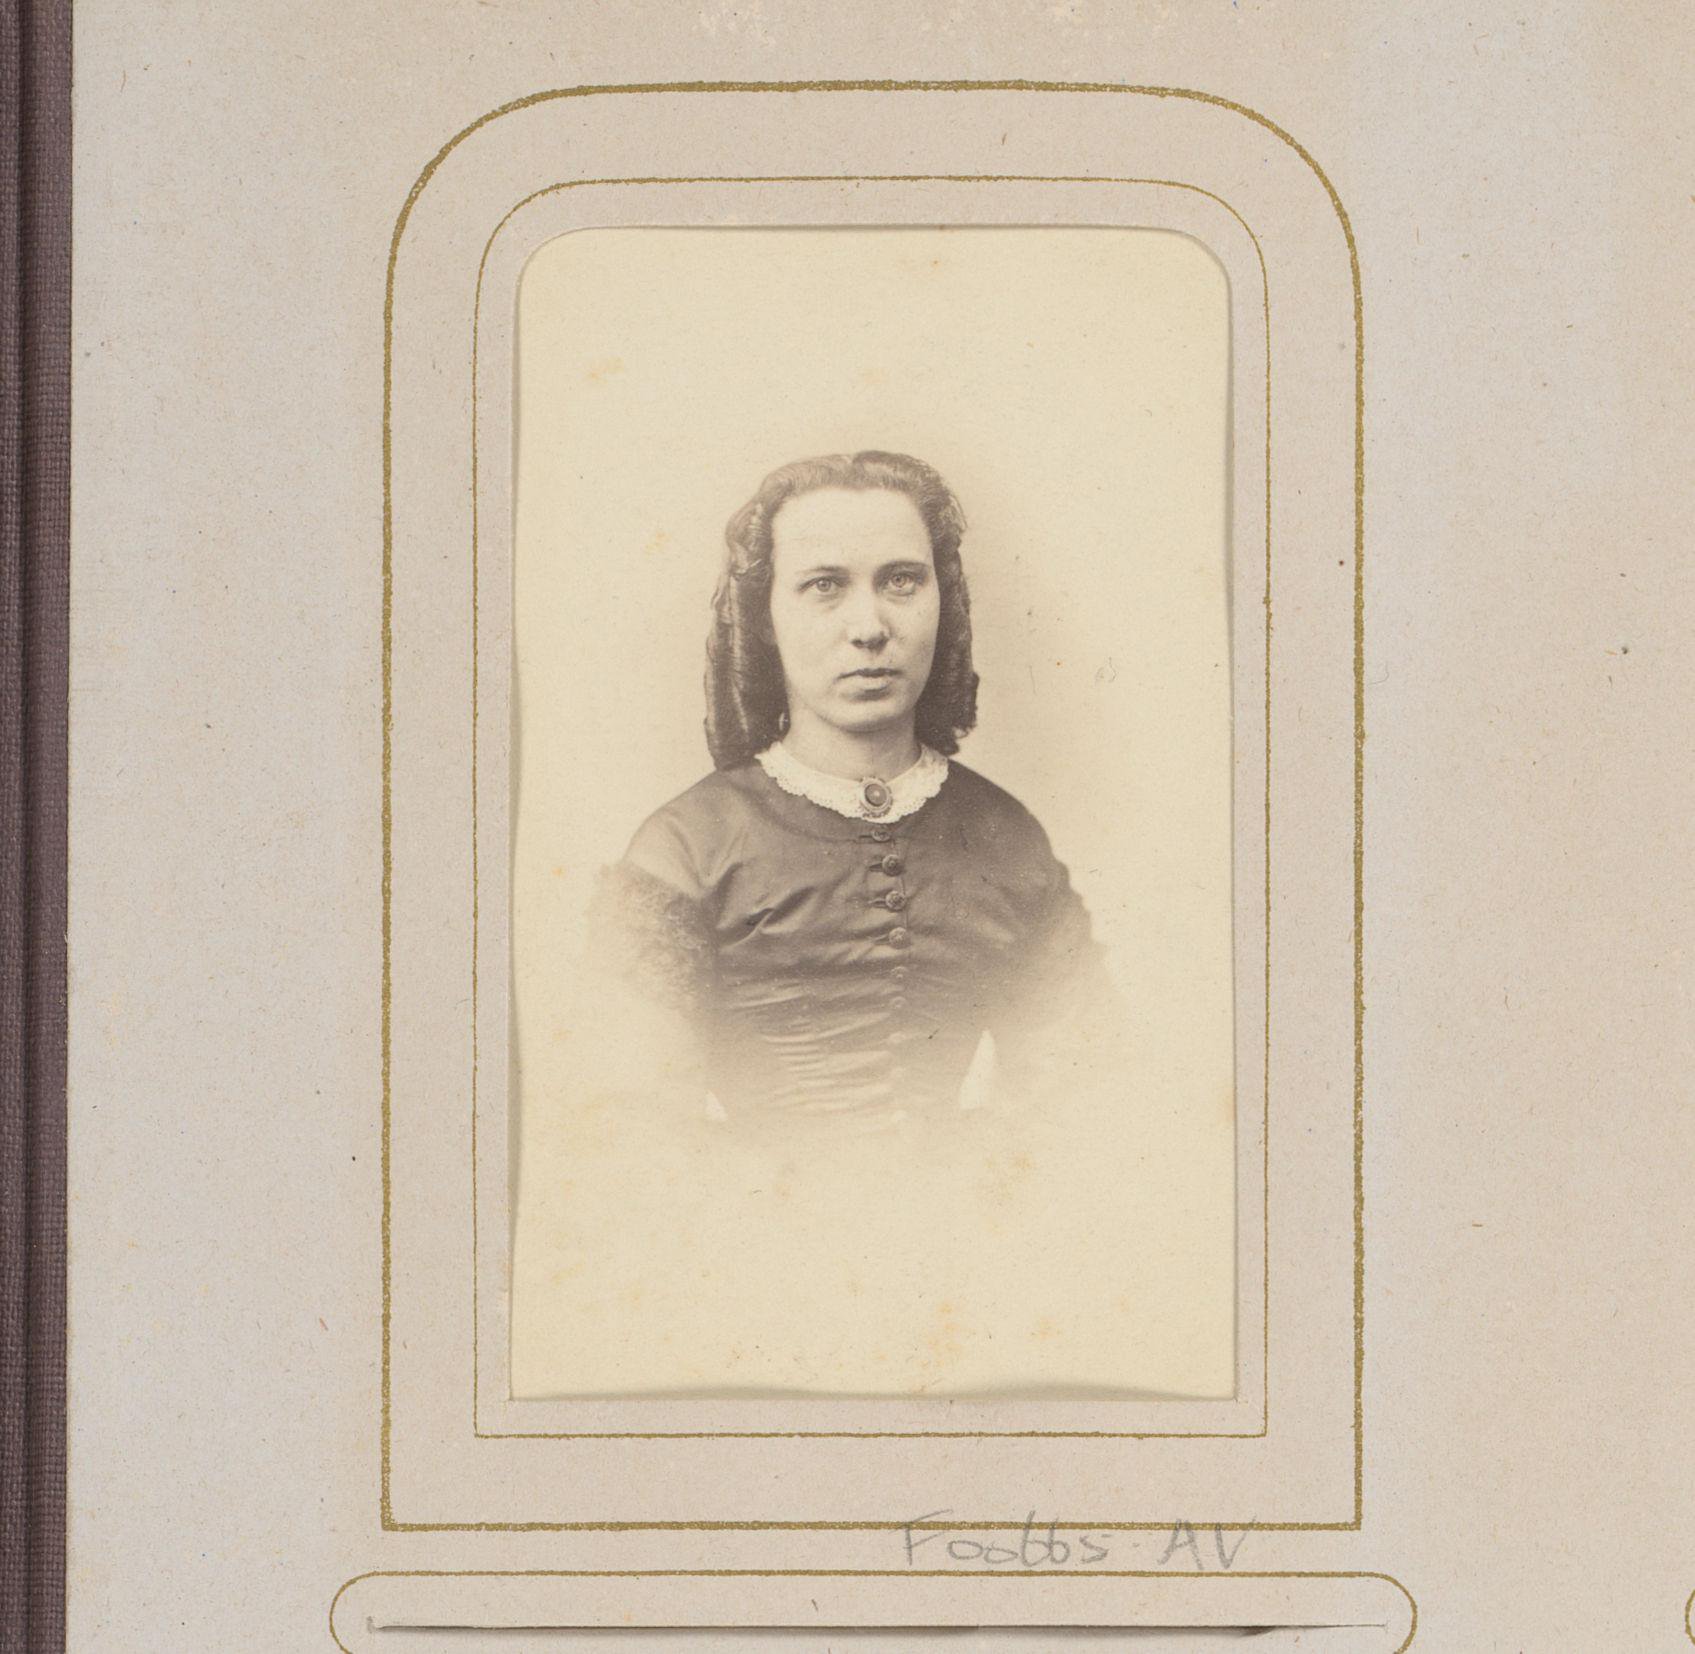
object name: photograph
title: Portret van een vrouw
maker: eduard fuchs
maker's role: painter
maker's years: 1832-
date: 1859-1870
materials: cardboard, photographic support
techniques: albumen print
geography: leeuwarden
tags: historical persons - bb - woman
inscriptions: inscription: ‘Photographie/ E. Fuchs/ Leeuwarden’